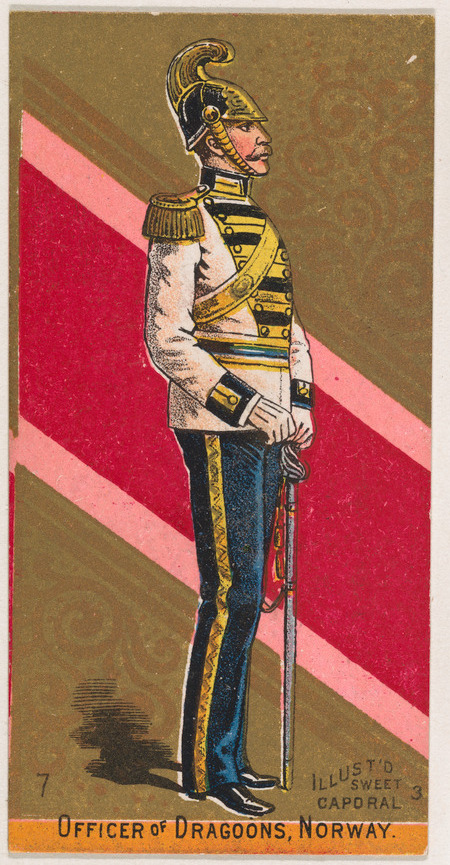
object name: print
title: Officer of Dragoons, Norway, from the Military Series (N224) issued by Kinney Tobacco Company to promote Sweet Caporal Cigarettes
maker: kinney brothers tobacco company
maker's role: publisher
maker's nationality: american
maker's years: 1869-2011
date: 1888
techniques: color lithograph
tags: military,swords,men,profiles